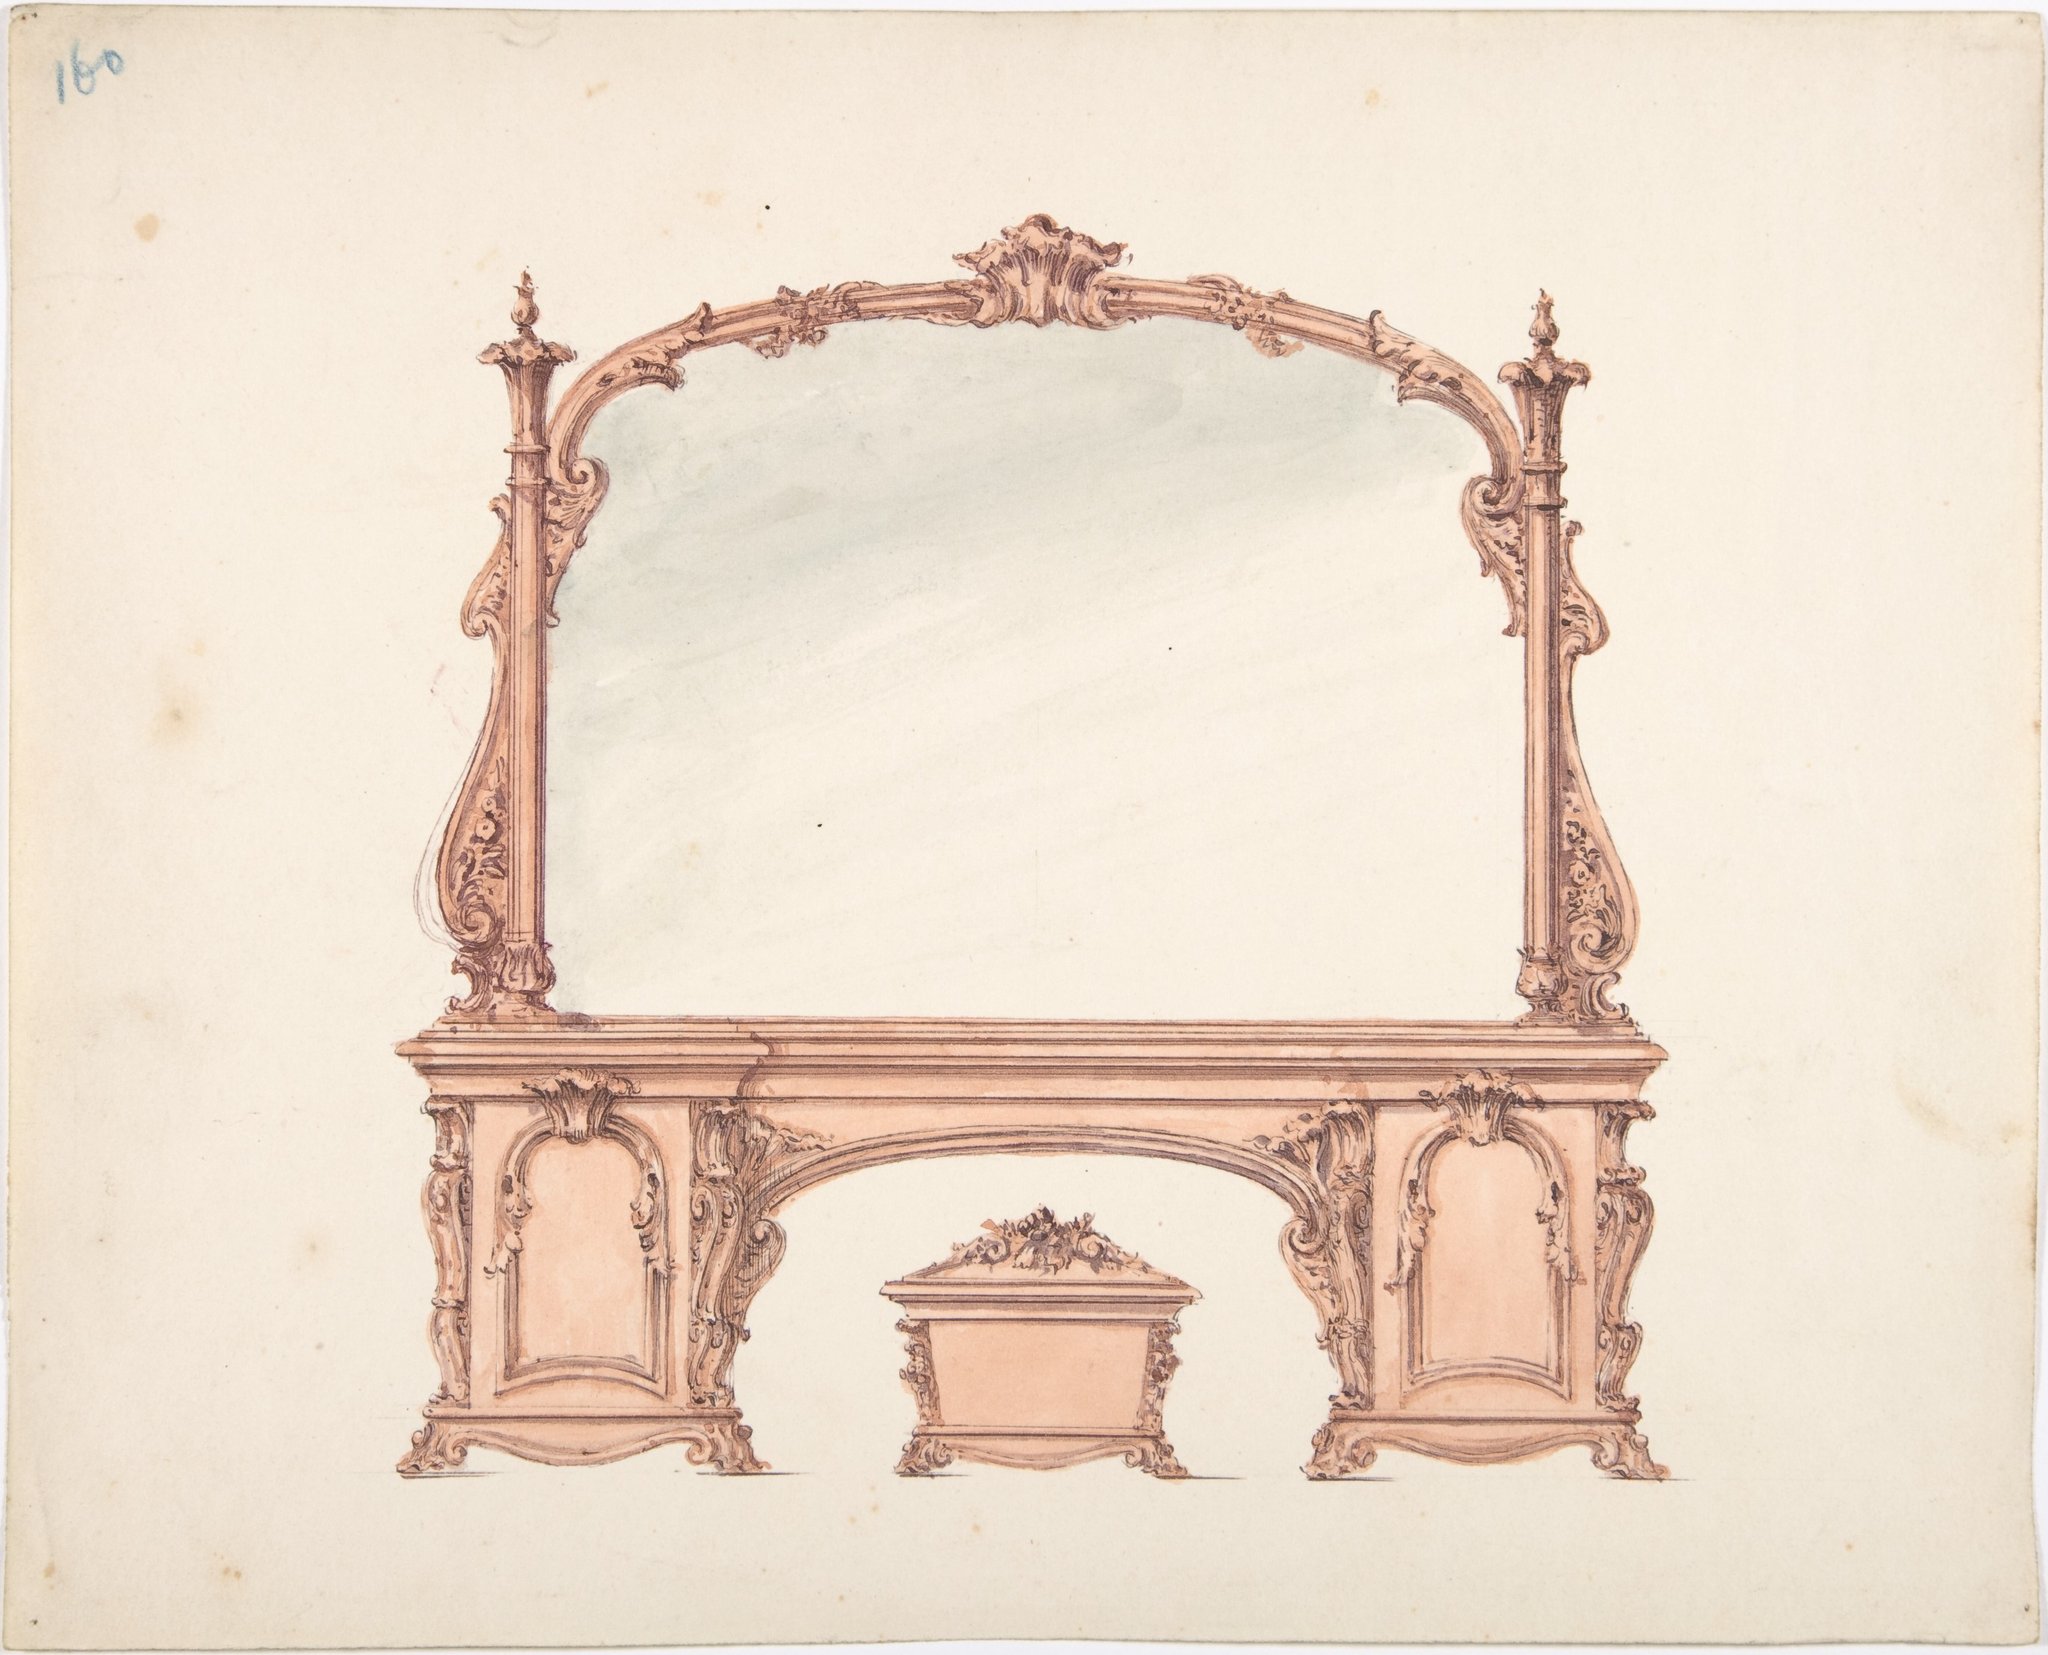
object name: drawing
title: Design for a Mirrored Sideboard with Rococo Ornament, and Casket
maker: anonymous, british, 19th century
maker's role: artist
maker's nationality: british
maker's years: 1800-1900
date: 1801-1833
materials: ink, watercolor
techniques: pen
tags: mirrors